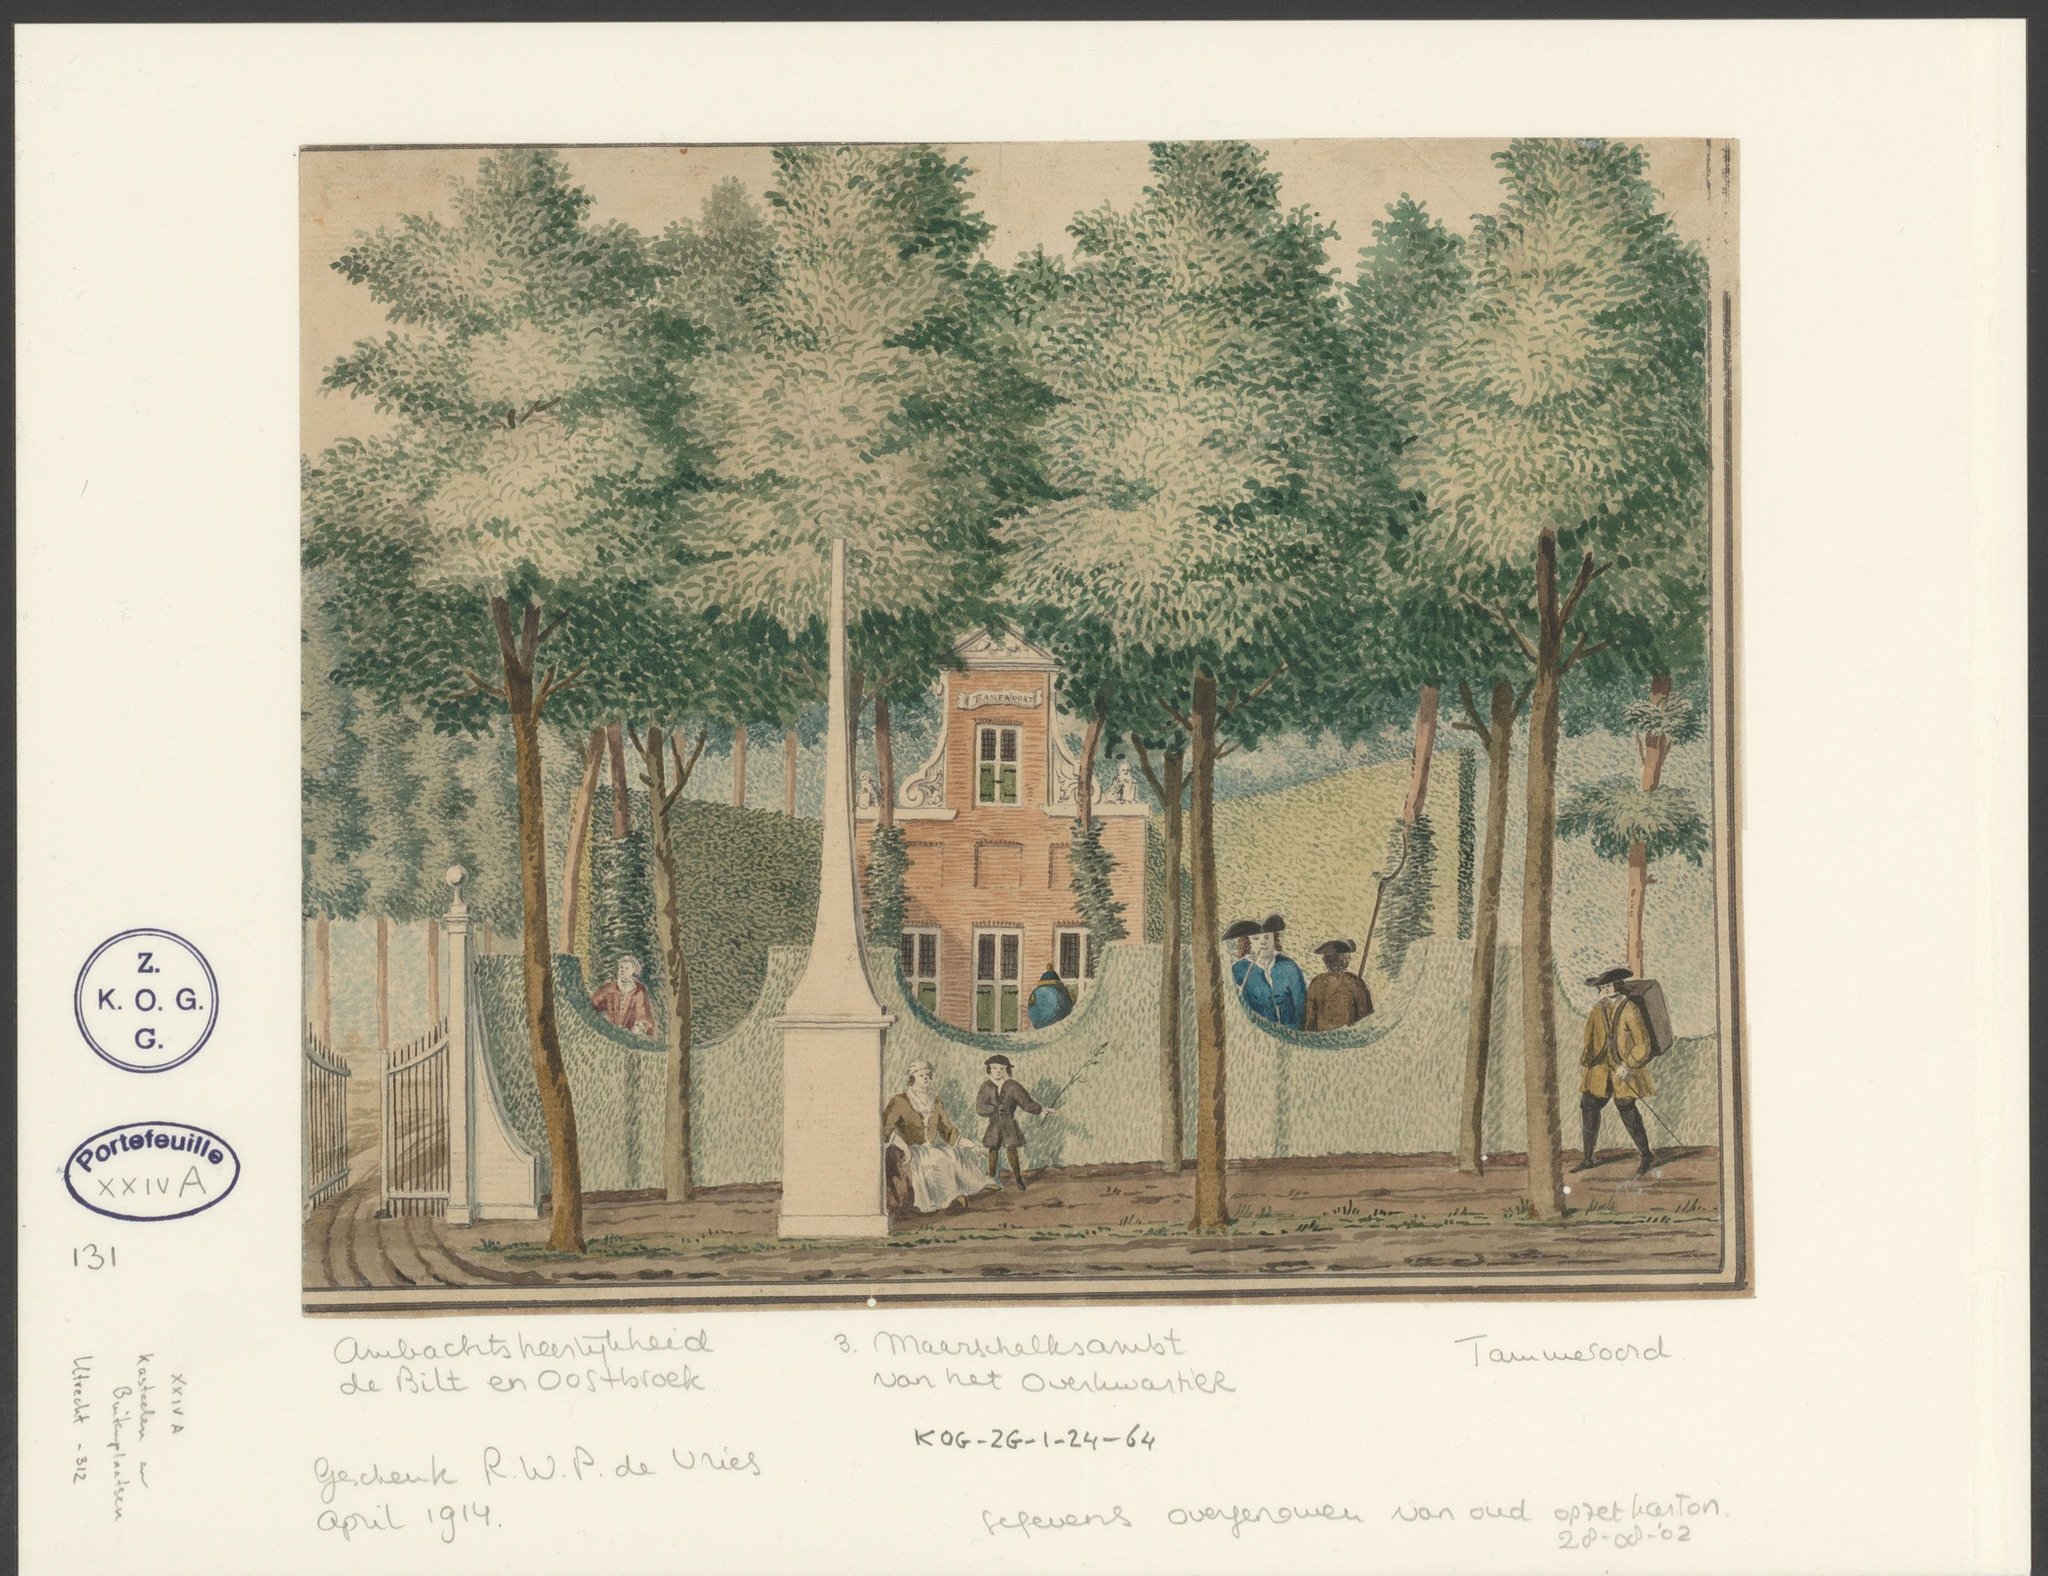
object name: drawing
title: Gezicht op Ambachtsheerlijkheid de Bilt en Oostbroek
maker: Anonymous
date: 1750-1799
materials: ink, paper, watercolor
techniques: brush, pen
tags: country-house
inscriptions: collector's mark: Lugt 1641, stamp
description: Onderwerpsrubrieken binnen de Atlas Zeden en Gewoonten: Zeden en Gewoonten in Engeren Zin, De Woning. Kastelen en buitenplaatsen. Utrecht (vervolg.).